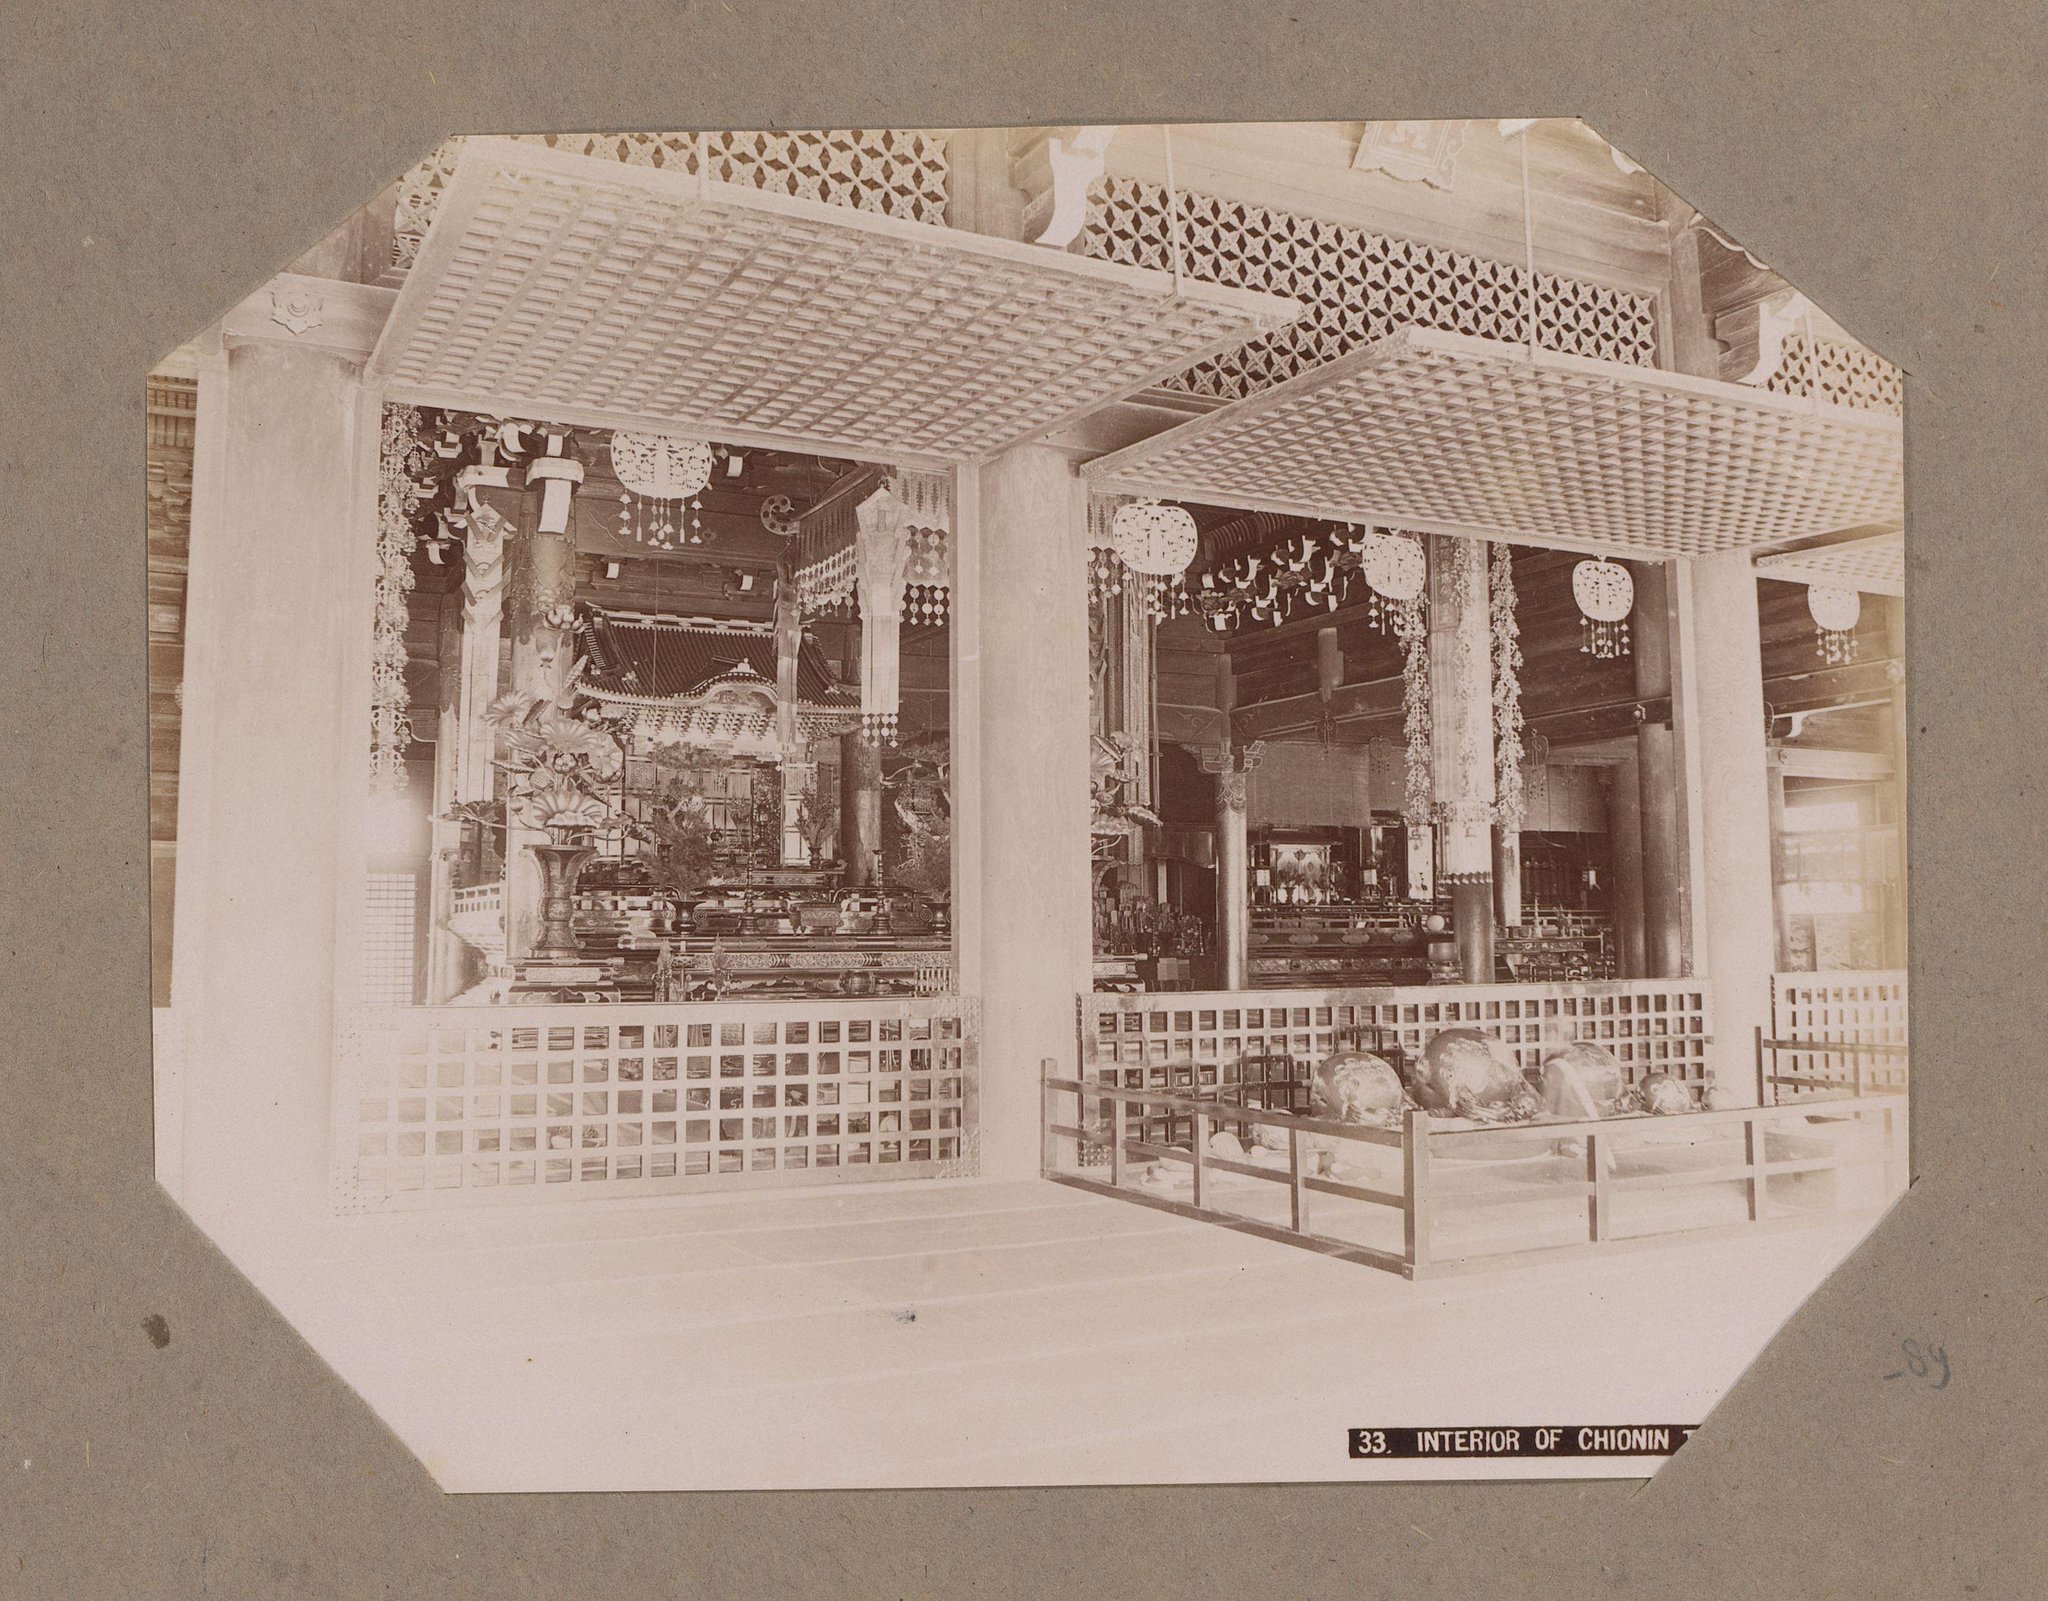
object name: photograph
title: Interieur van de Chion-in tempel in Kyoto, Japan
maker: Anonymous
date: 1890-1903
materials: paper, photographic support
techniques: albumen print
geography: kyoto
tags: temple, shrine ~ hinduism, buddhism, jainism, interior ~ representation of a building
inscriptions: inscription: ‘33. Interior of Chionin Temple. Kioto’